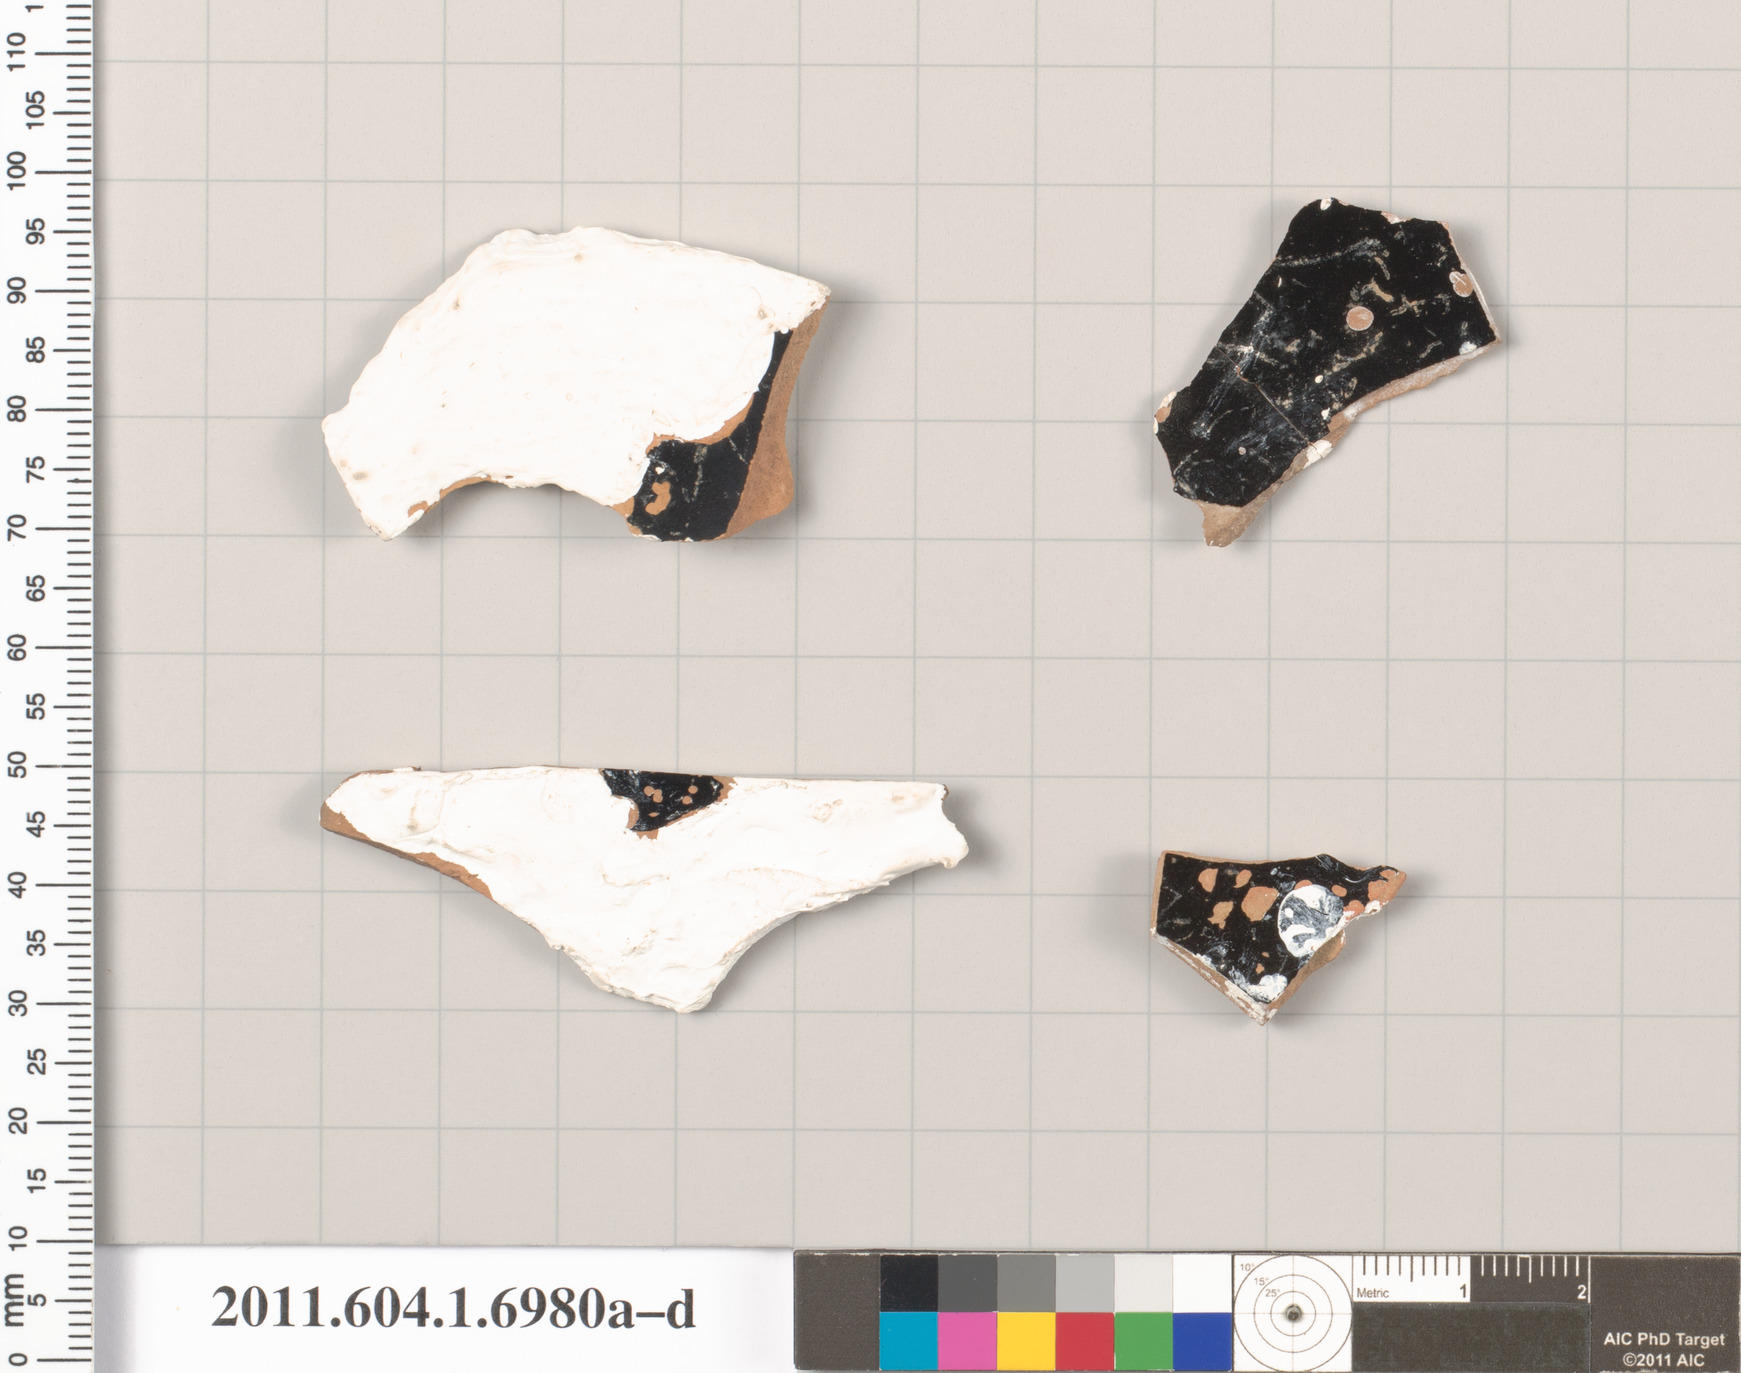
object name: kylix fragment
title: Terracotta fragments of a kylix (drinking cup)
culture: greek, attic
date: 490-470 BCE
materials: terracotta